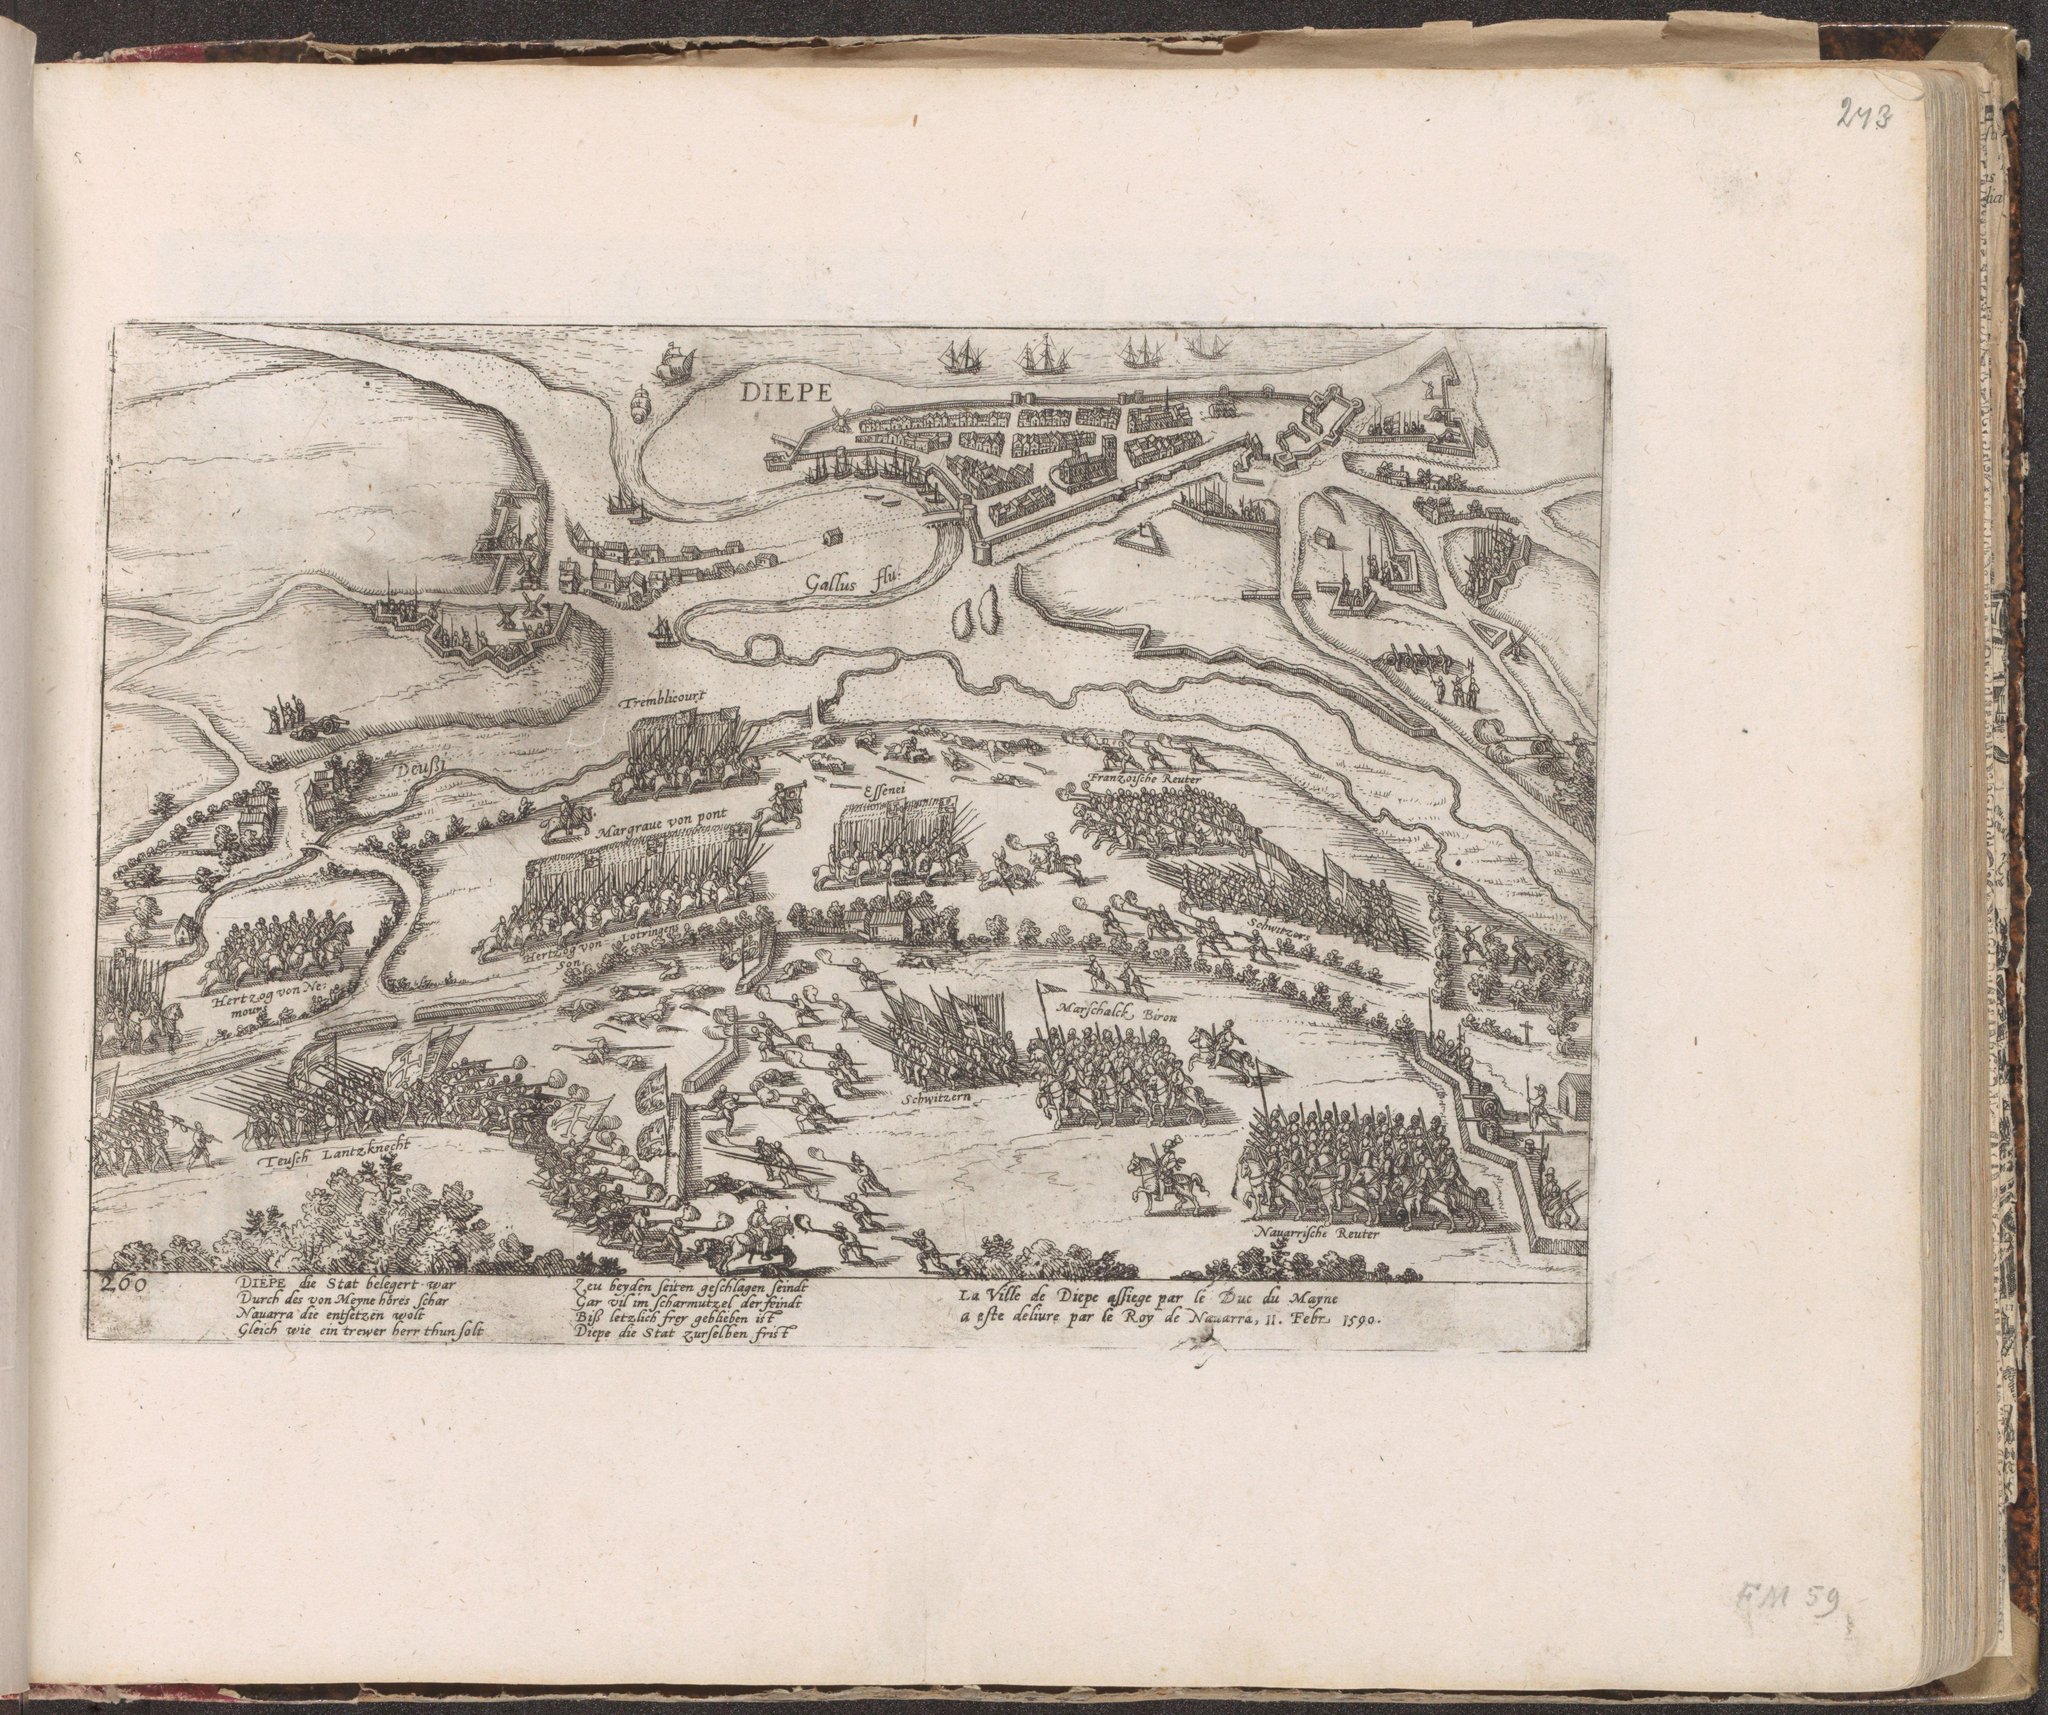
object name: history print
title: Serie 4: Franse, Duitse en Engelse Gebeurtenissen, 1576-1610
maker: frans hogenberg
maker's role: print maker, publisher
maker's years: 1538-1590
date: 1590-1612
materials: paper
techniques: etching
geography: cologne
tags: paris, hendrik iv (koning van frankrijk en navarra), battle, fighting in general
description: Het belegerde Dieppe ontzet door Hendrik IV, 11 februari 1590. De veldslag op de voorgrond, in de verte een plattegrond van de stad Dieppe in vogelvluchtperspectief. Met onderschrift van 8 regels in het Duits en 2 regels in het Frans. Linksonder genummerd: 260. De prent maakt deel uit van een album.